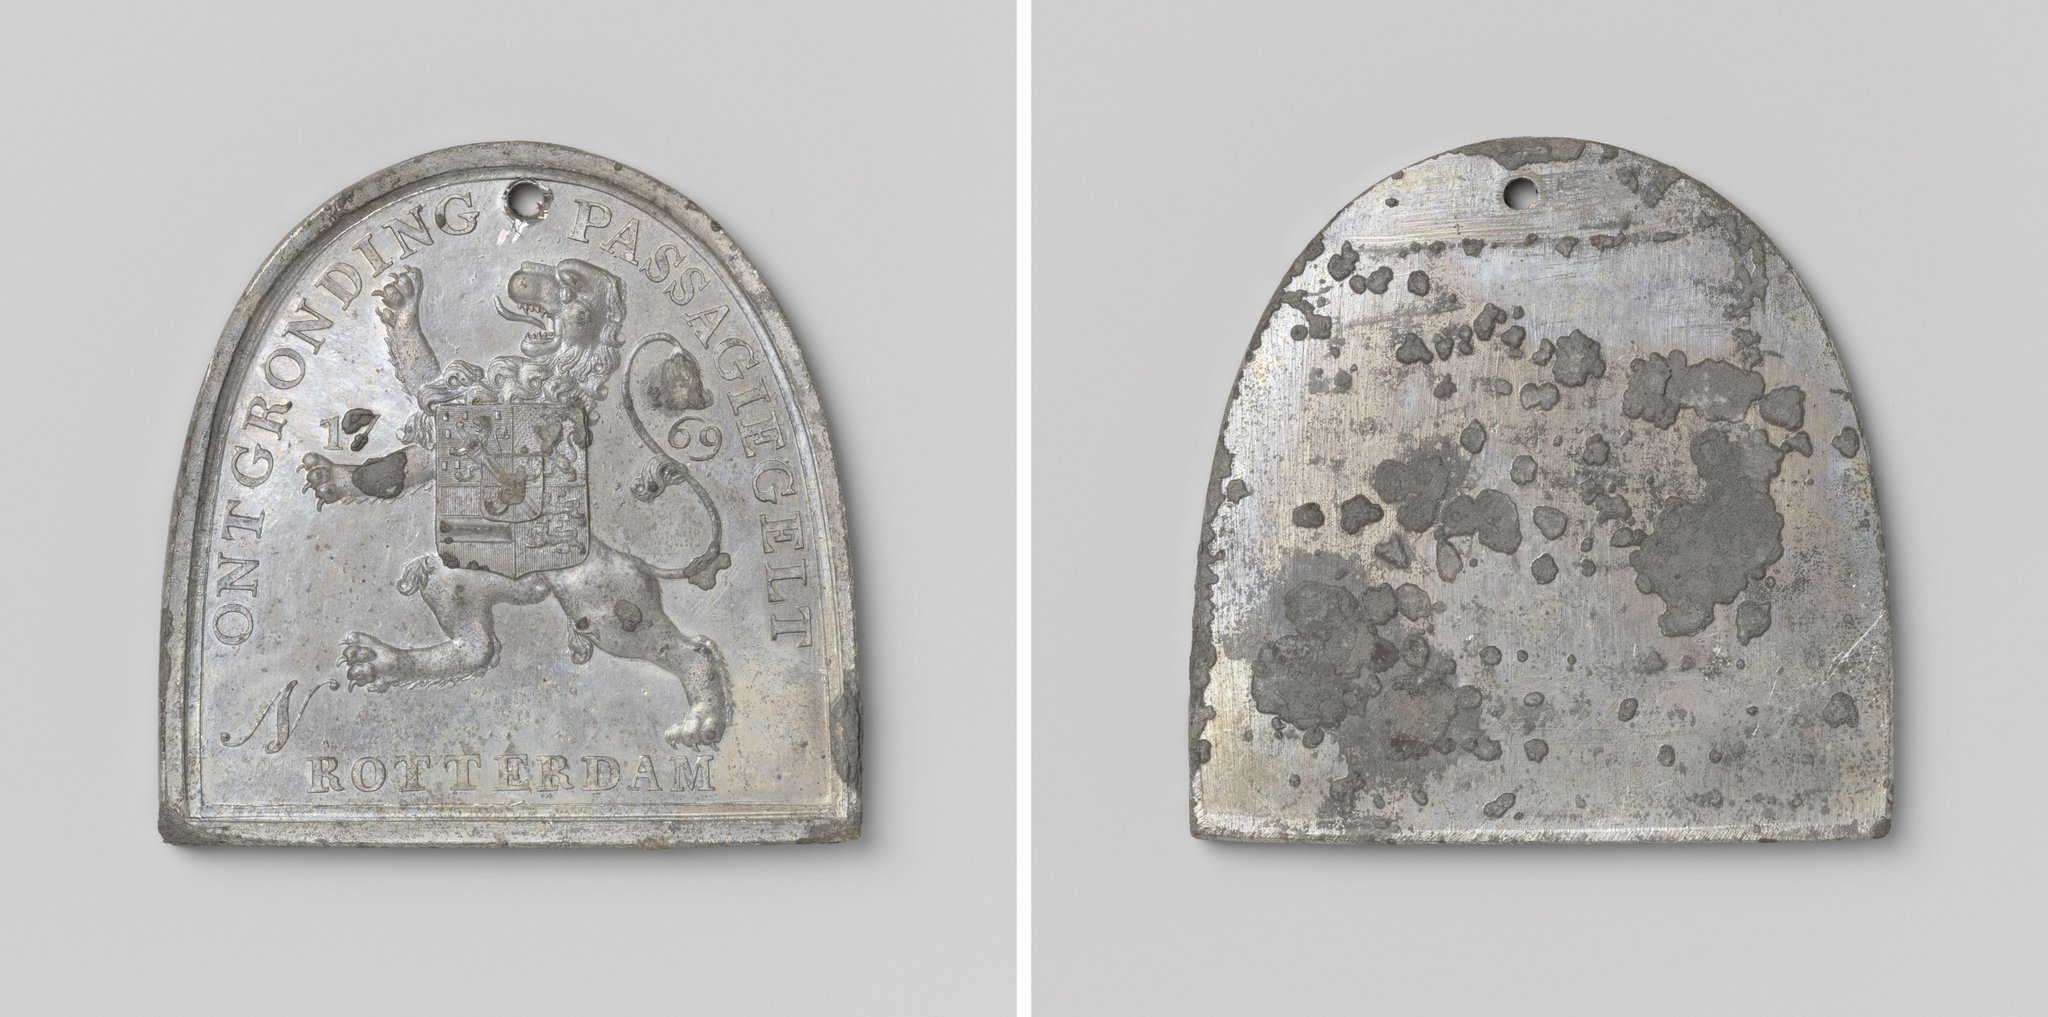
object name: identification medal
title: Ontgronding te Rotterdam, penning bedoeld als bewijs voor turfdragers, -vullers of -tonners om turf in te mogen voeren uit de nieuw ontgronde venen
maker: Anonymous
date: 1769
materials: lead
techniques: casting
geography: rotterdam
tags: rotterdam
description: Eenzijdige loden penning met ronde boven- en rechthoekige onderzijde, en gat erin. Voorzijde: staande leeuw met wapenschild op borst tussen jaartal binnen omschrift. Keerzijde: blanco.